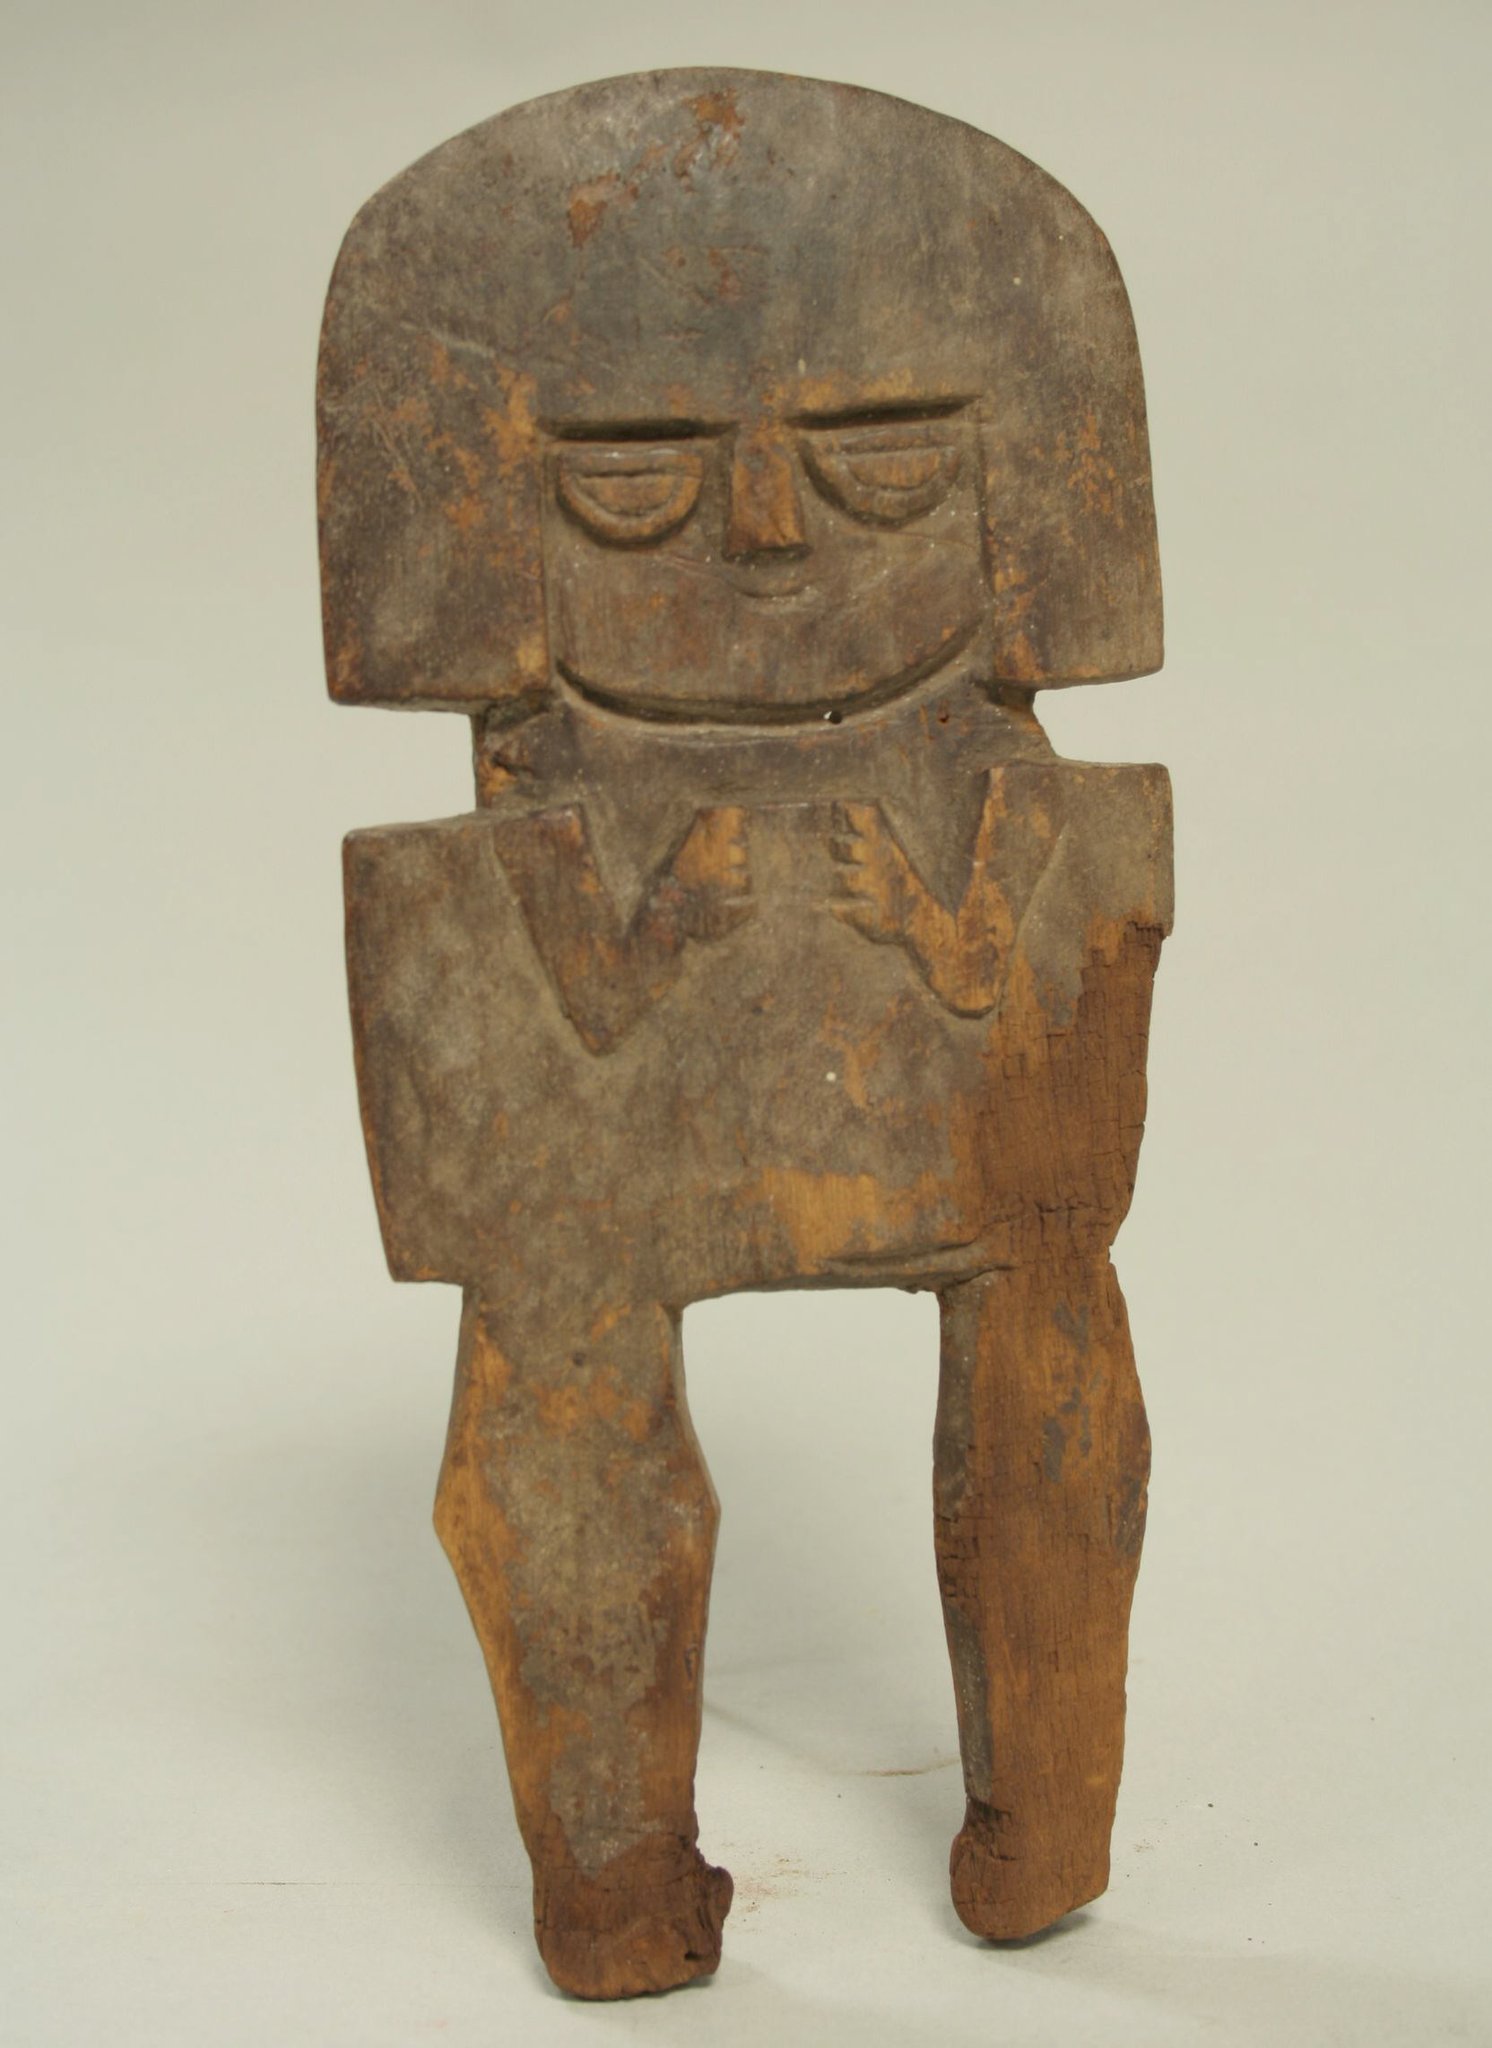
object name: figure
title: Double-sided Wooden Figure Carving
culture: peruvian, north or central coast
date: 701-1566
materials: wood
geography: peru